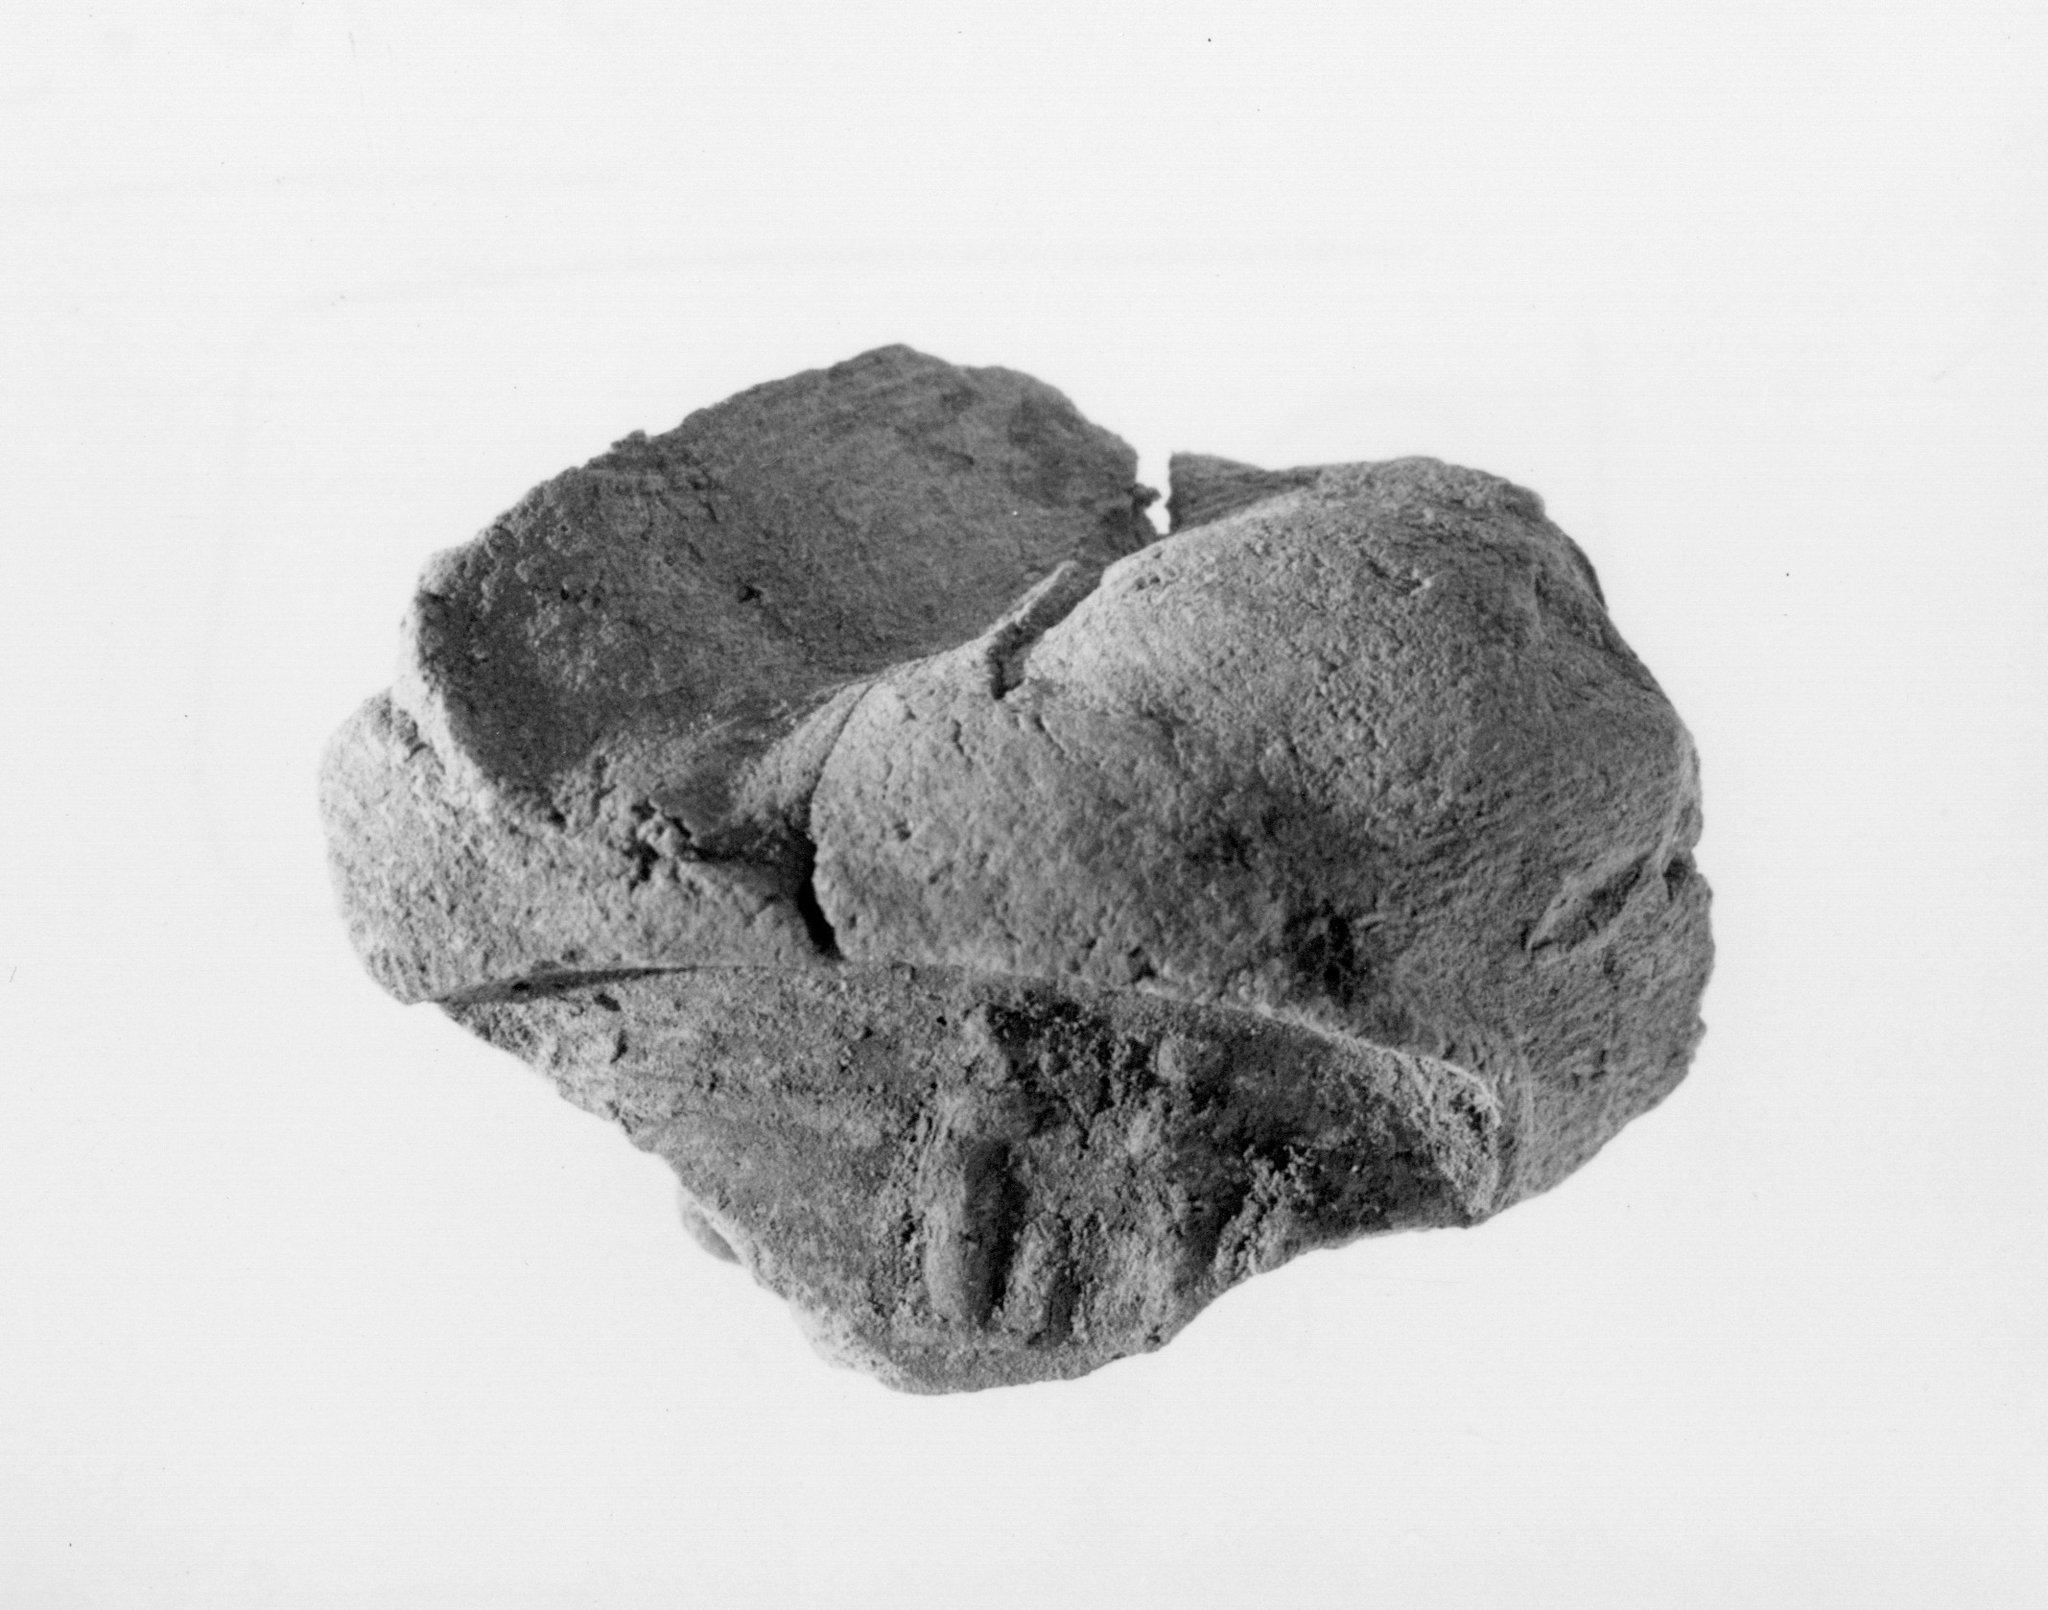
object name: sealing, nebmaatre, amenhotep iii,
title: Document Sealing With the Throne Name of Amenhotep III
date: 1390-1352 BCE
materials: mud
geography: egypt